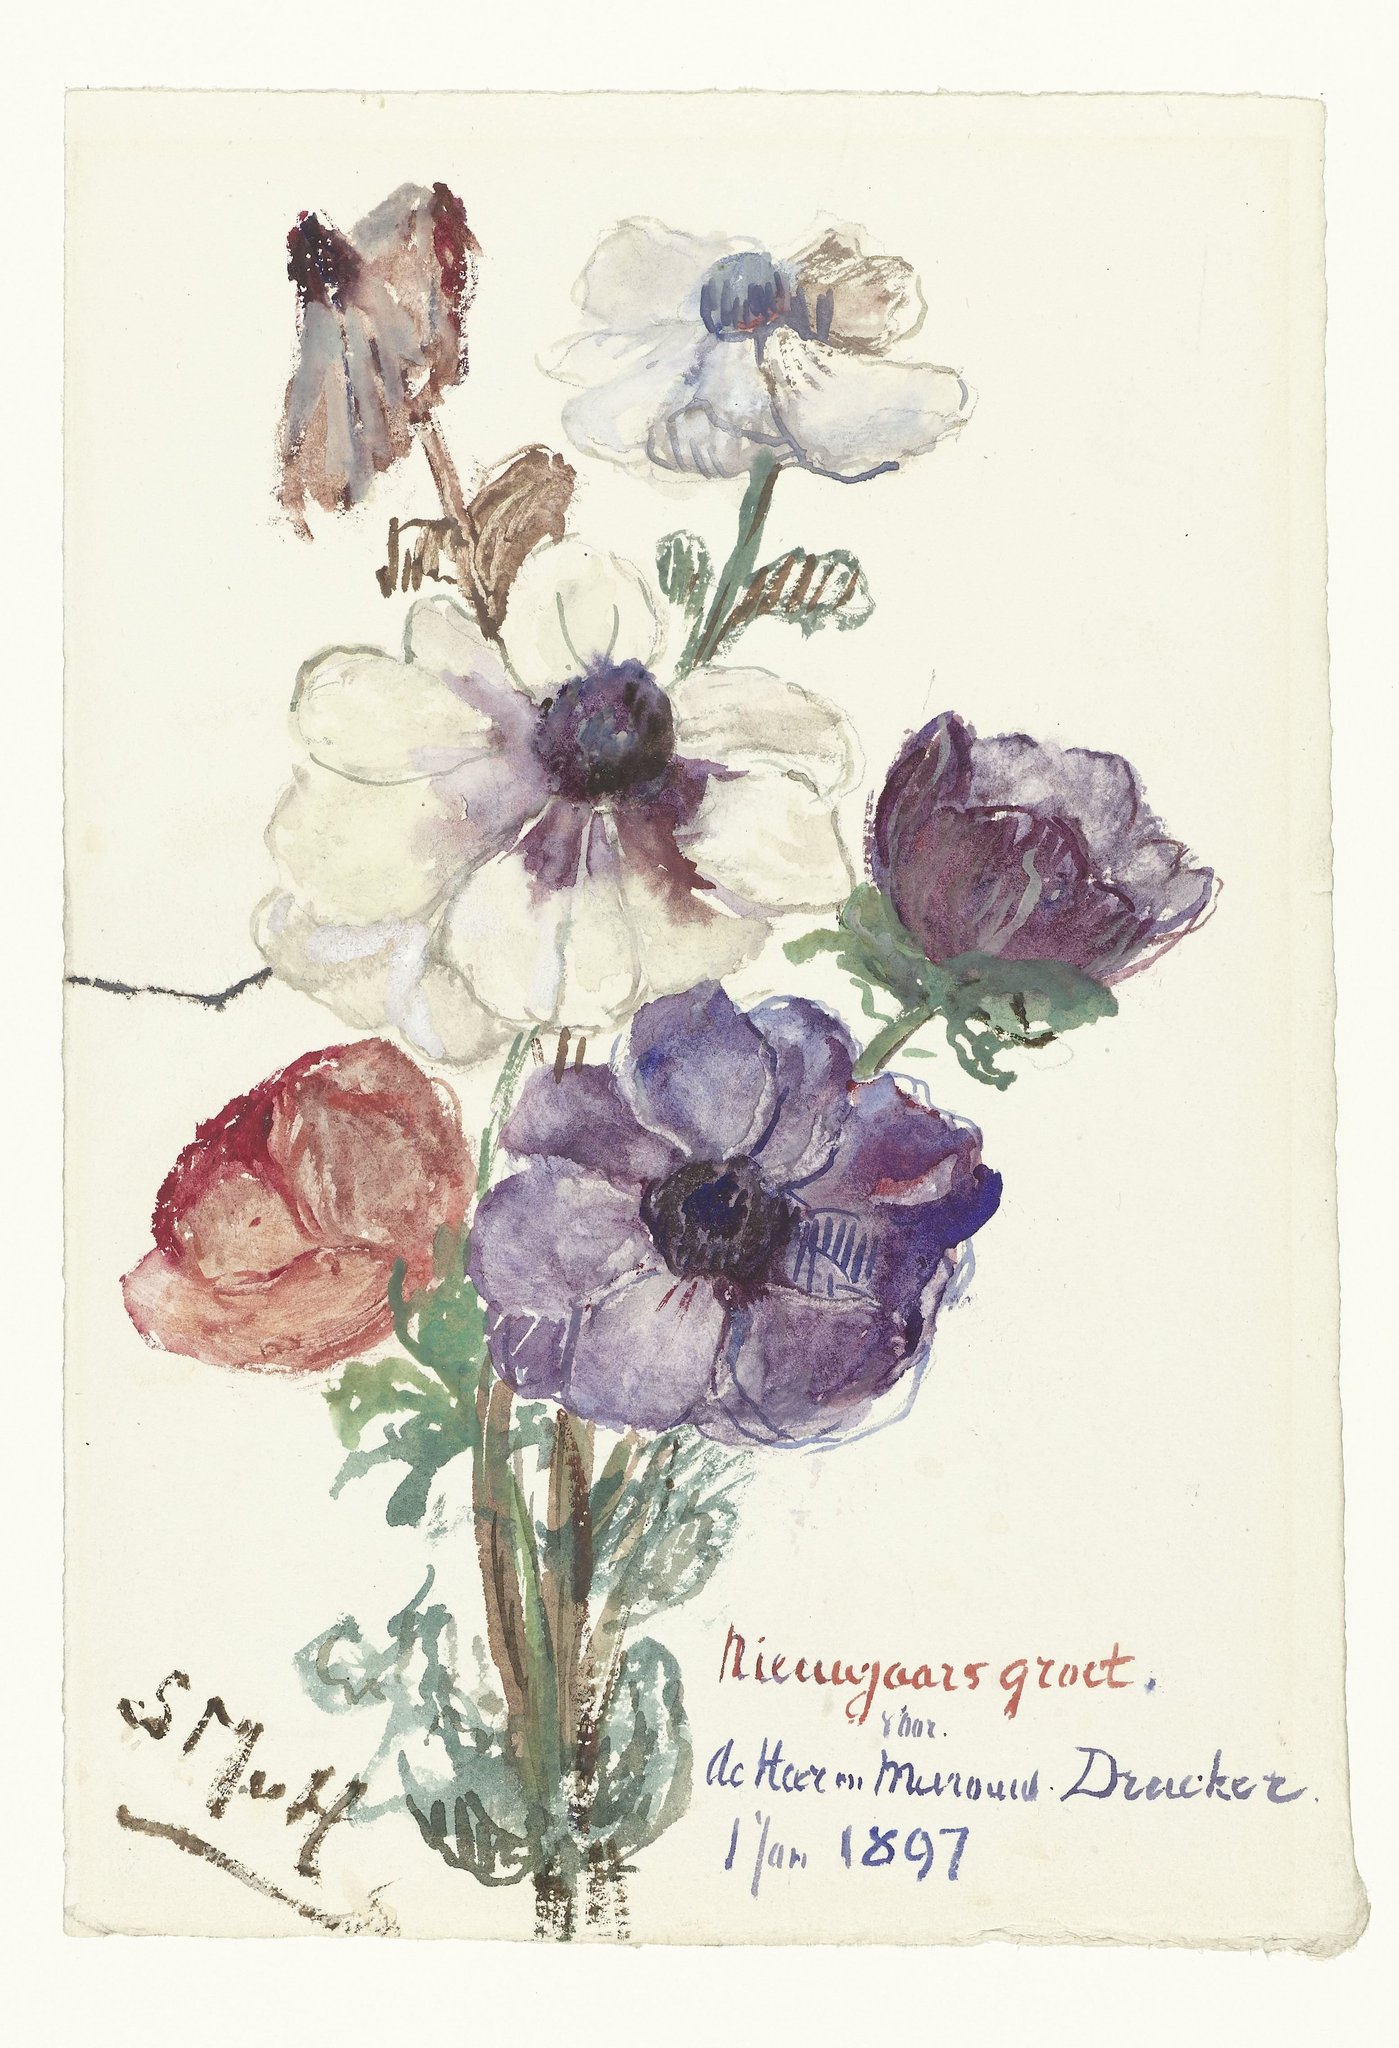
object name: drawing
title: Nieuwjaarsgroet met anemonen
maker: sientje mesdag-van houten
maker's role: draughtsman, painter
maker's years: 1834-1909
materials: paper, watercolor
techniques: brush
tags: cut flowers; nosegay, bunch of flowers, flowers: anemone